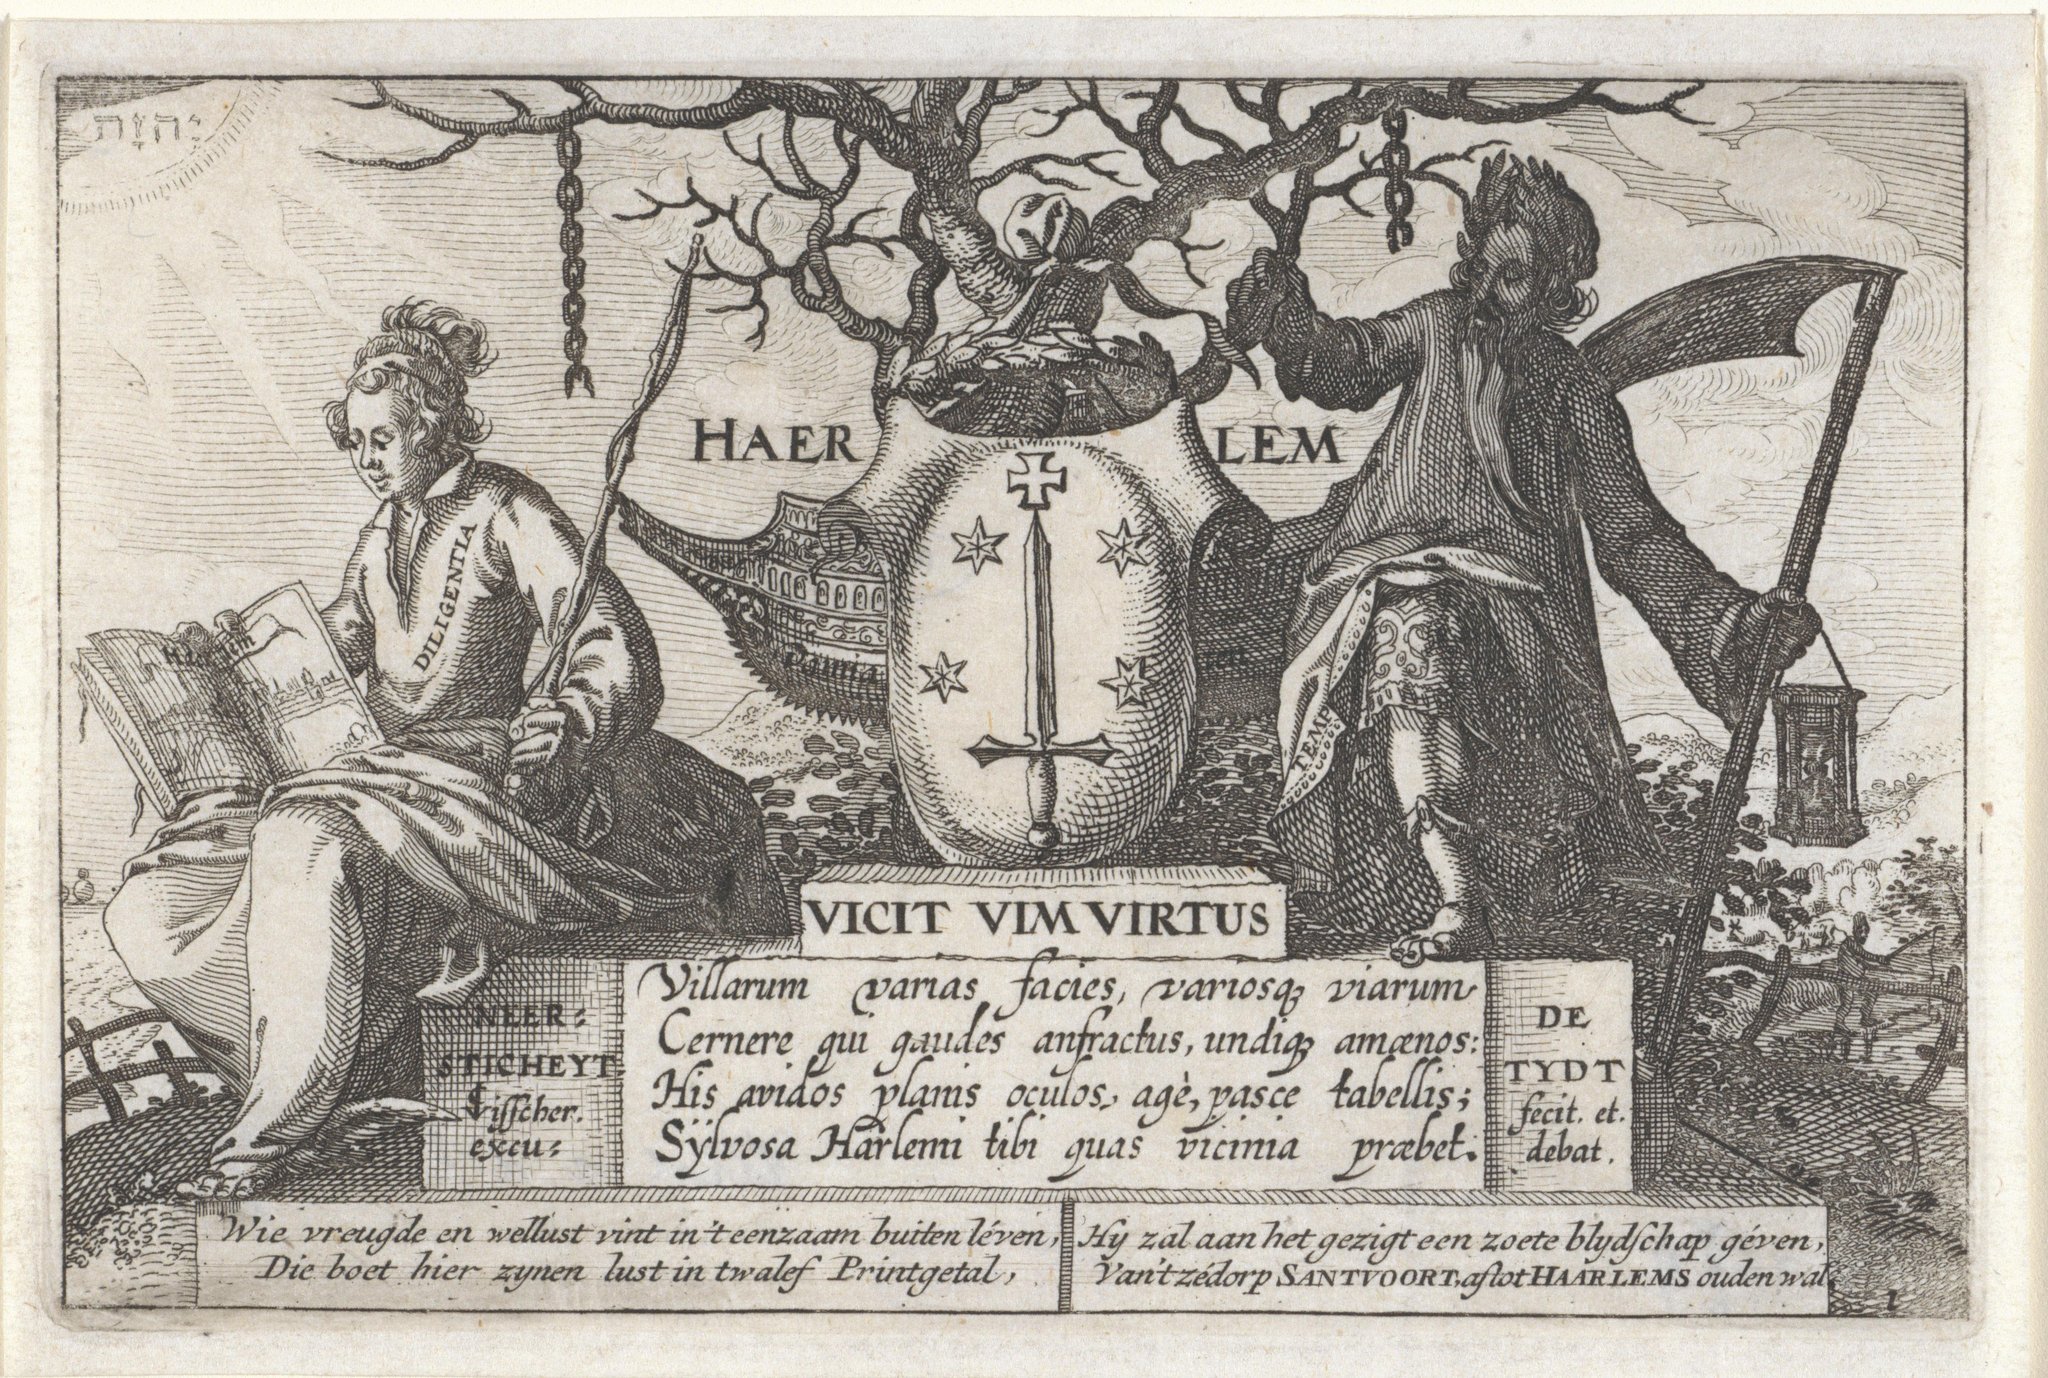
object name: print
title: Diligentia en Tempus bij het wapen van Haarlem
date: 1728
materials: paper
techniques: engraving, etching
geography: amsterdam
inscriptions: title: ‘HAERLEM VICIT VIM VIRTUS’, caption: ‘Wie vreugde en wellust vint in 't eenzaam buiten leven. Dieboet hier zynen lust in twalef Printgetal. Hy zal aan het gezigt een zoete blydschap geven. Van 't zedorp SANTVOORT, af tot HAERLEMS ouden wal.’, collector's mark: Lugt 2228, signature and address: ‘CIVisscher fecit. et. excudebat.’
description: In het midden het wapen van Haarlem, bekroond met een lauwerkrans en boomtakken. Achter het wapen een schip en de tekst HAERLEM. Onder het wapen: VICIT VIM VIRTUS. In het midden vier regelige titel: Villarum varias facies...vicinia praebet. Links zit Naarstigheid of Diligentia met een open boek op schoot en staf in de hand. Rechts staat Tempus als gevleugelde oude man met zeis en zandloper Met bijschriften NEER=STICHEYT en DE TYDT.Onderschrift: Wie vreugde enwellustvint in 't eenzaam buiten leven...tot HAERLEMS ouden wal.